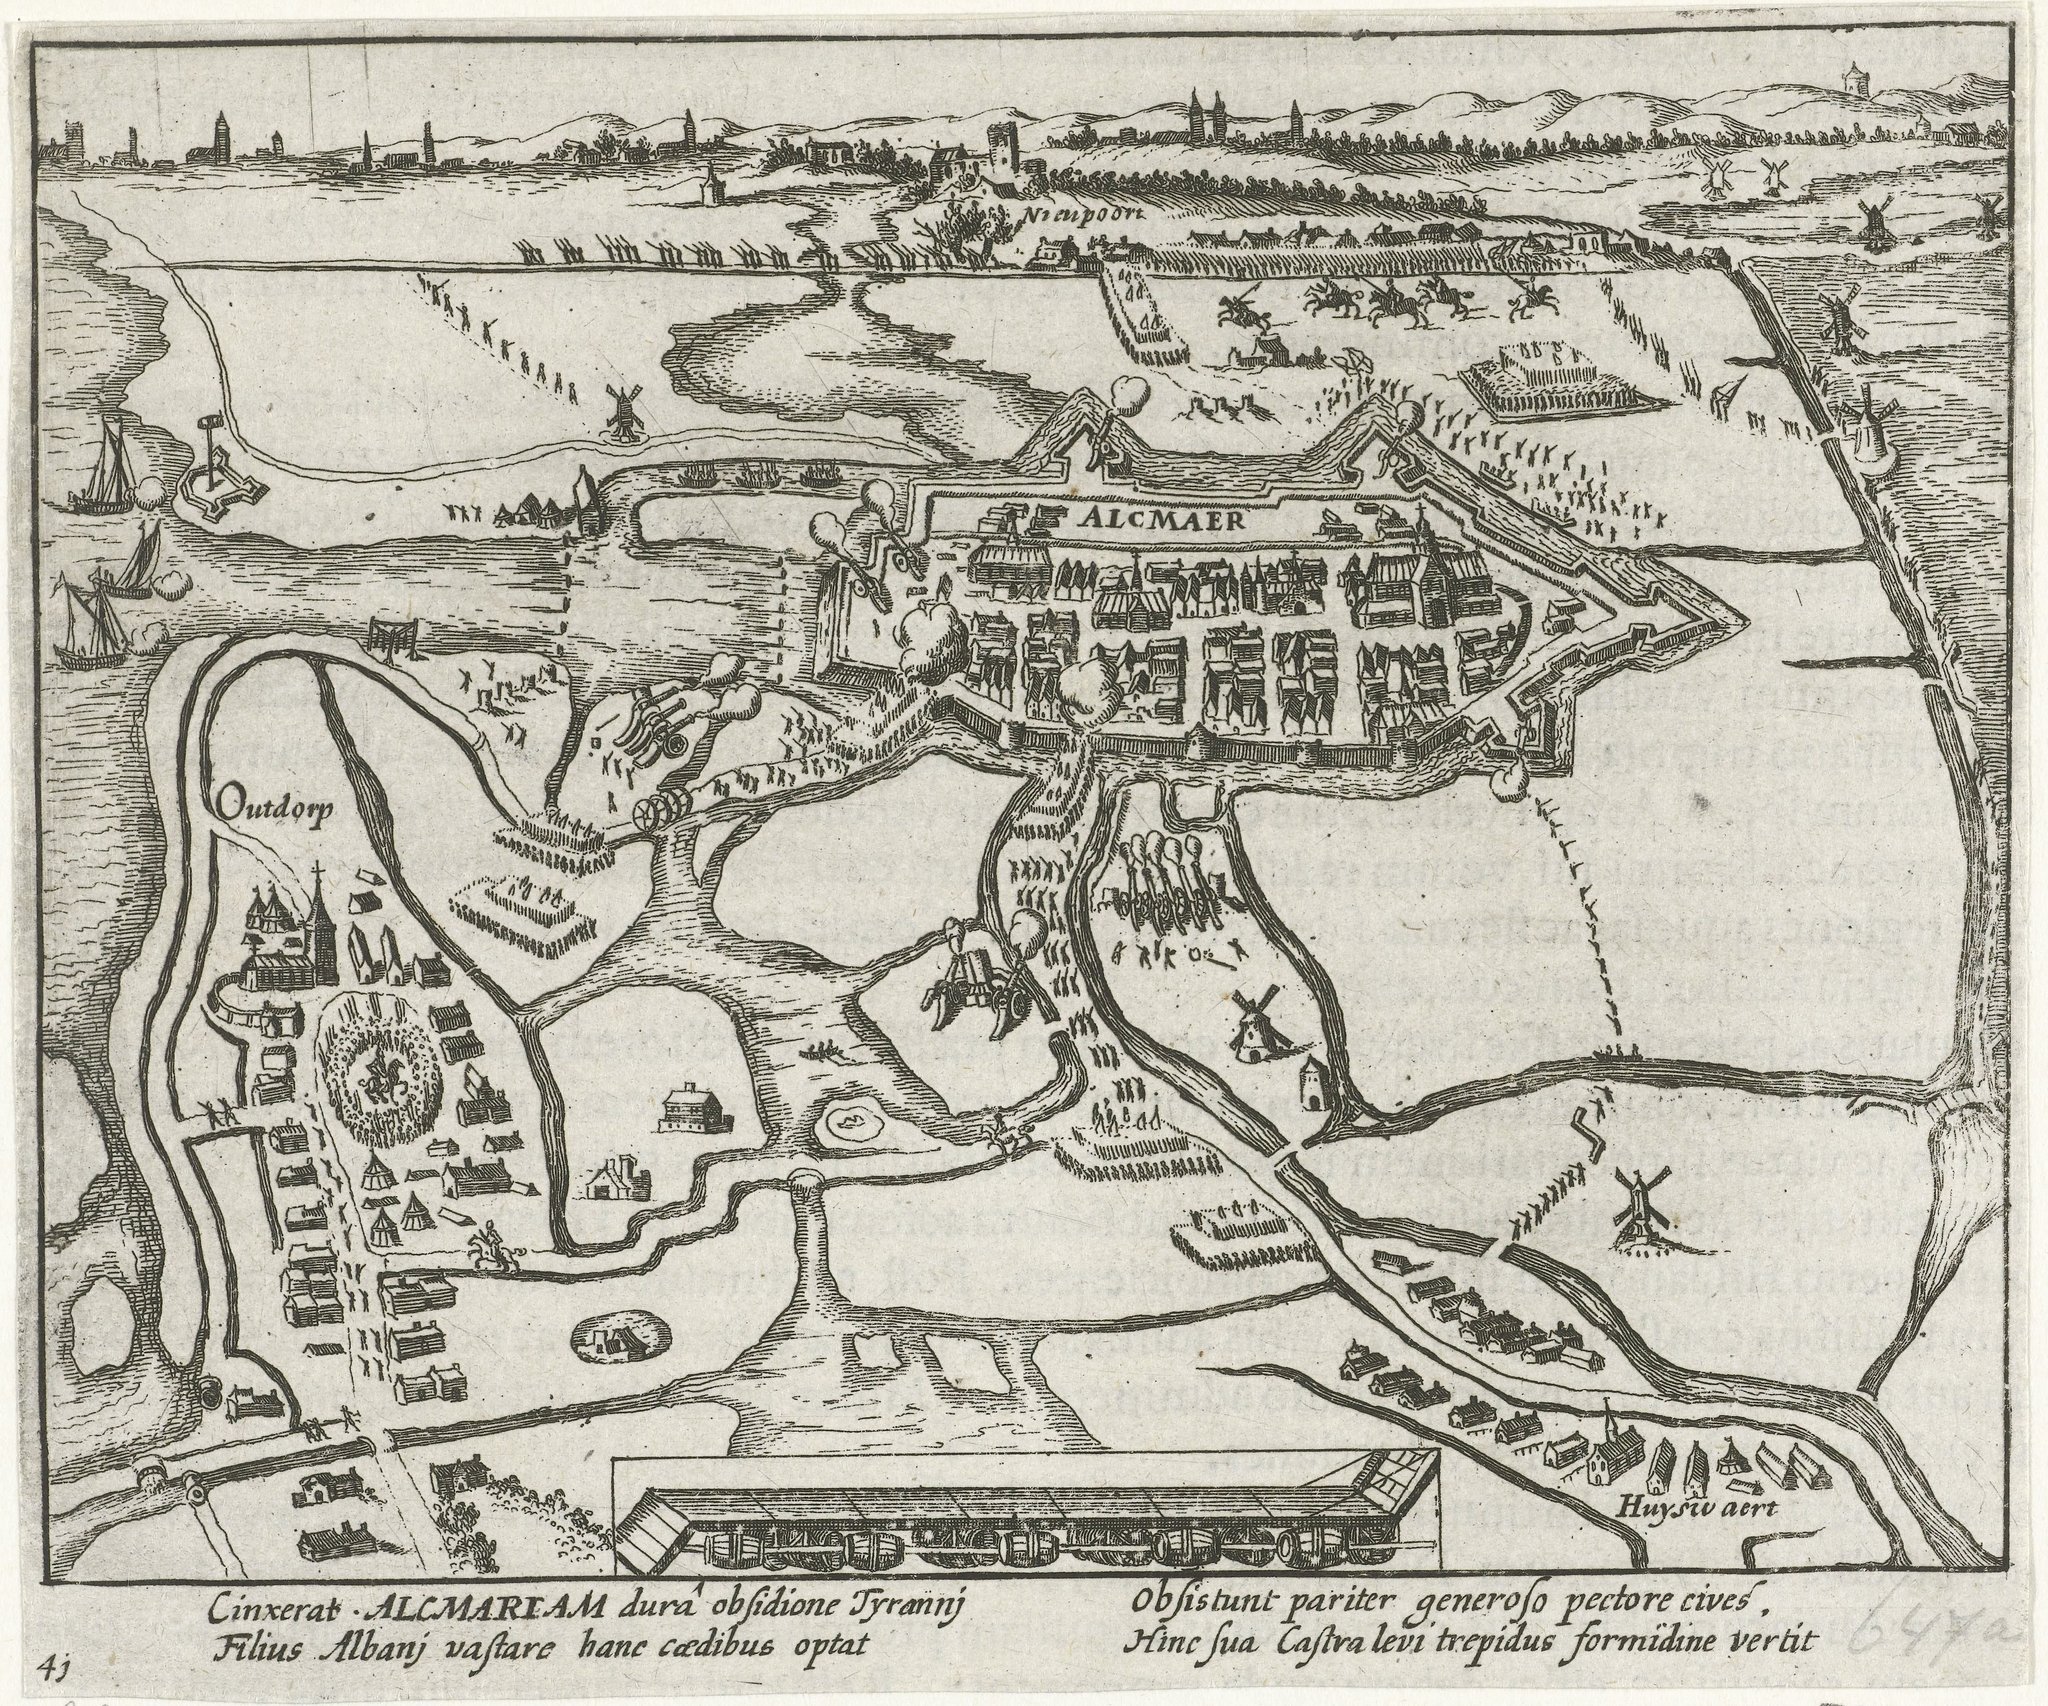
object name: history print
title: Beleg van Alkmaar, 1573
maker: simon frisius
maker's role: print maker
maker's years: 1570-1628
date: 1613-1615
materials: paper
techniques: etching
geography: northern netherlands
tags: siege, position war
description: Plan van het beleg van Alkmaar, augustus en september 1573. Gezicht op de stad en het omringend gebied. Op de voorgrond de legerplaats in Oudorp van de belegerende troepen onder bevel van Don Frederik, rechts de Schermer. Met onderschrift van 4 regels in het Latijn. Genummerd: 41. Bedrukt op achterzijde met tekst in het Latijn.